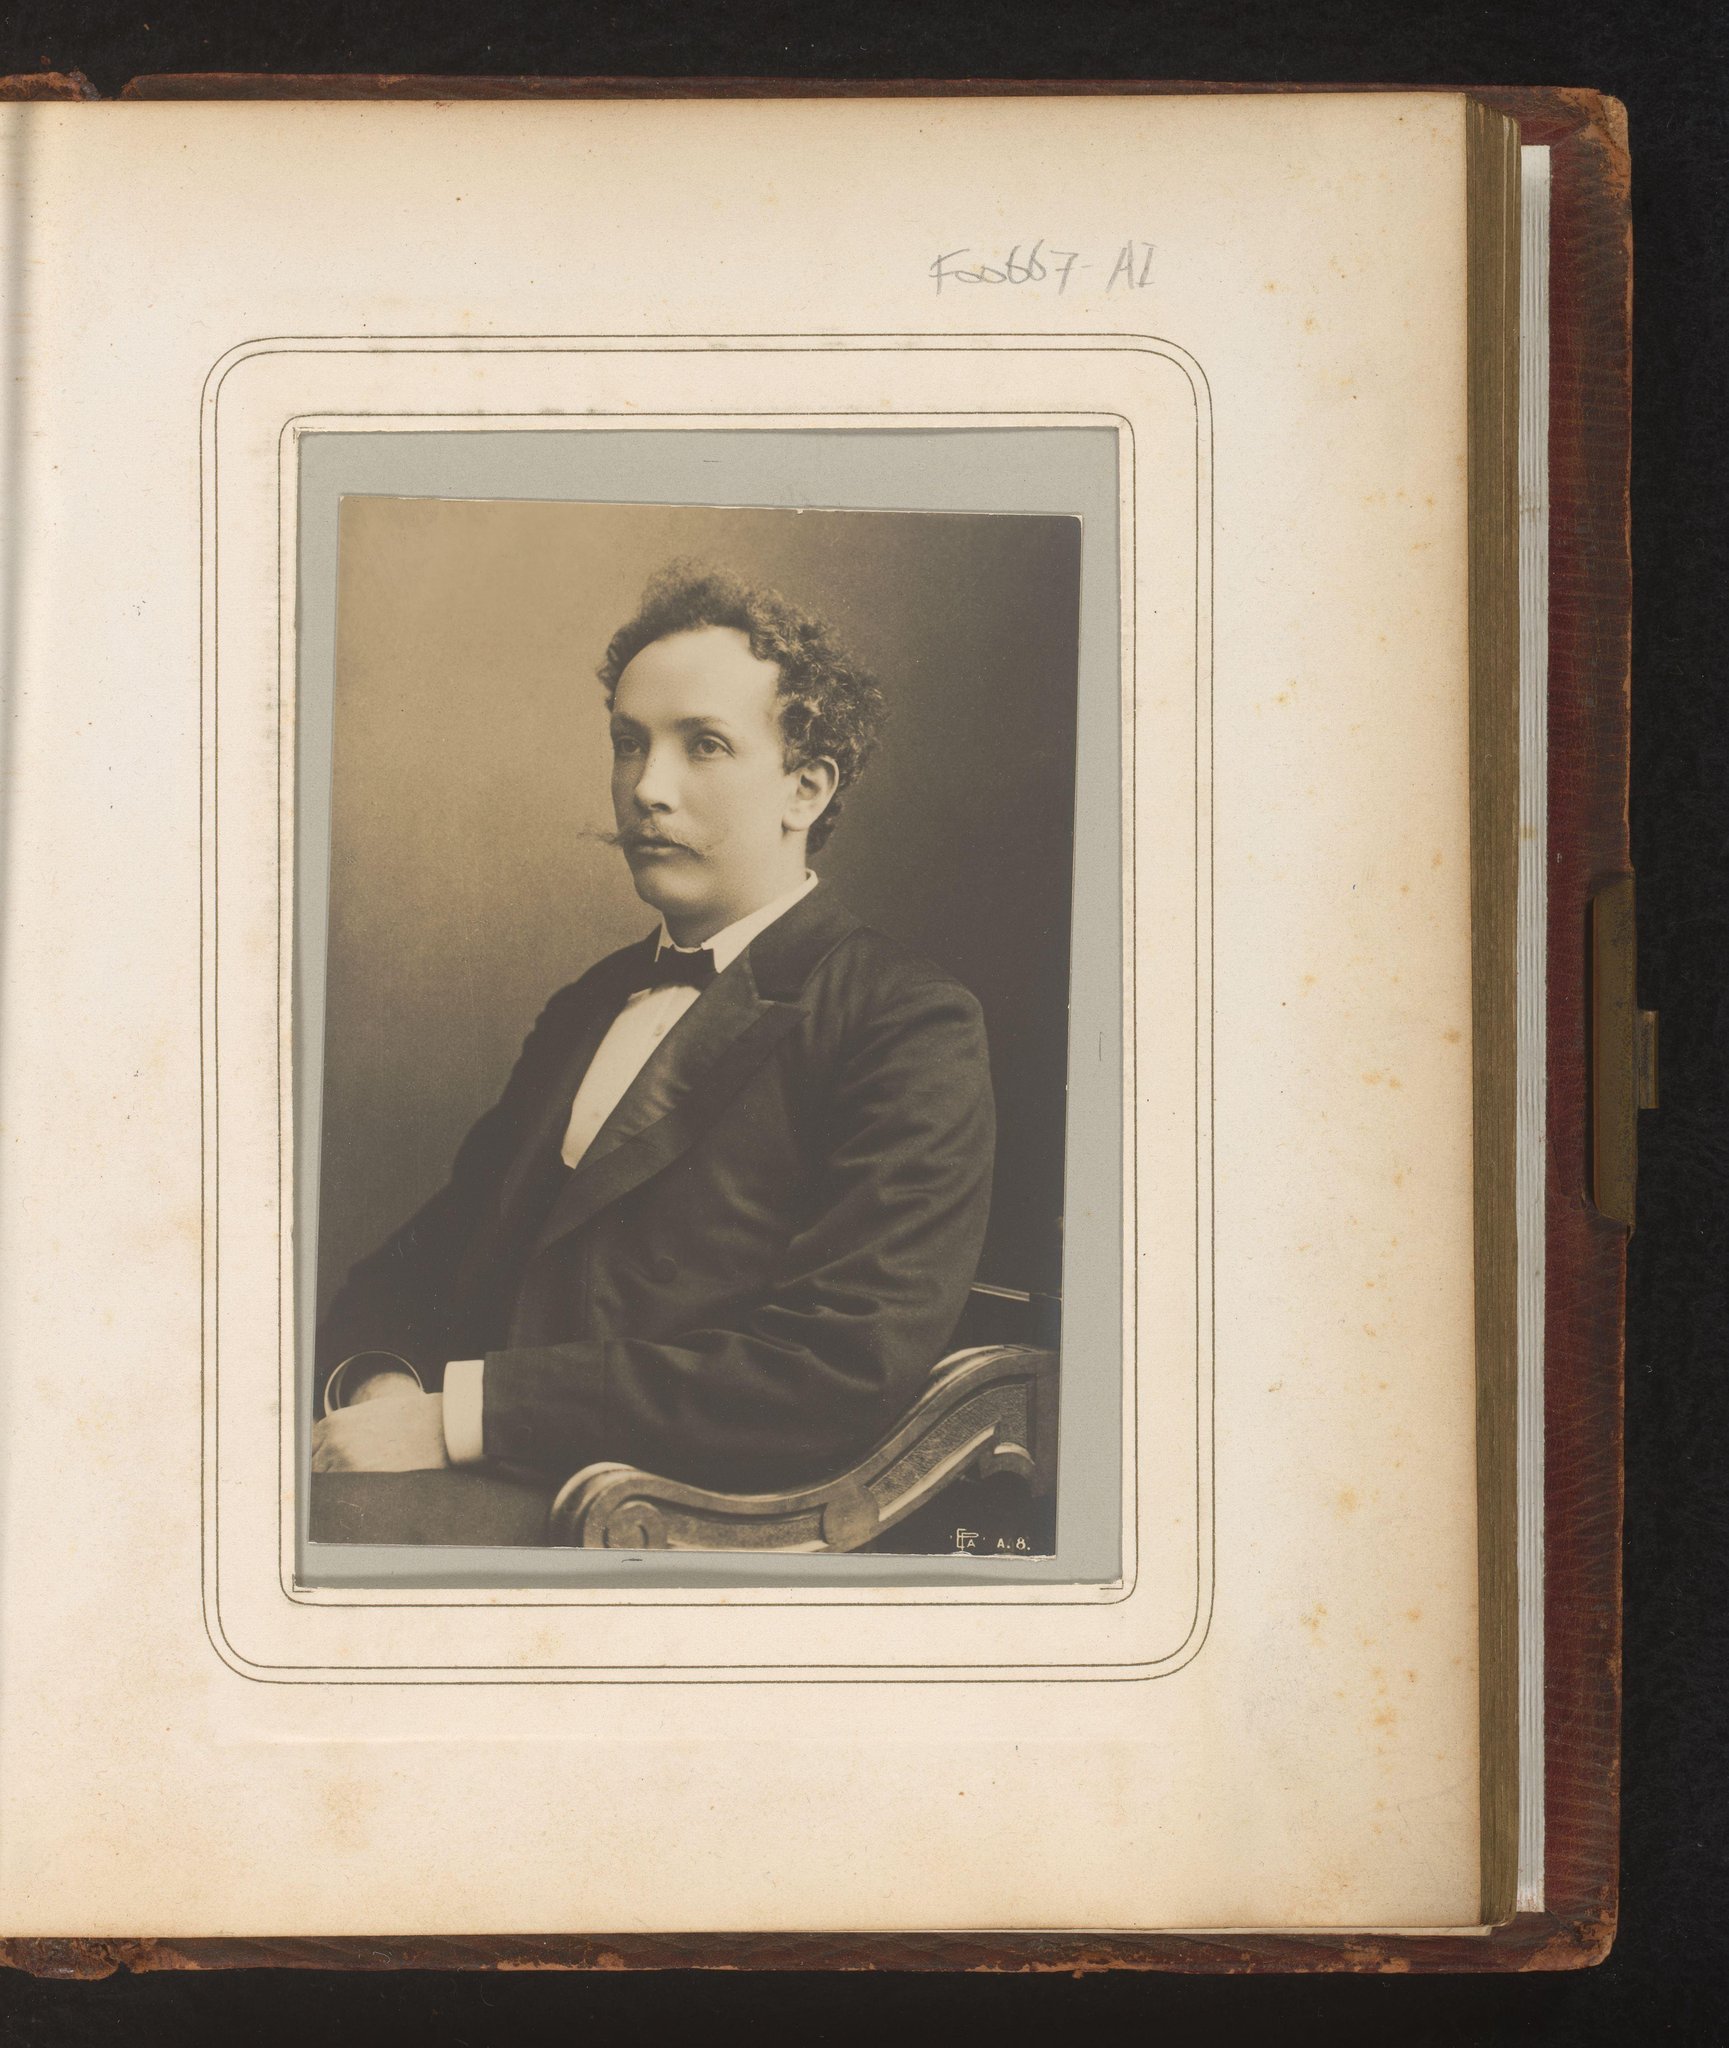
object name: photograph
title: Portret van een man gezeten in een stoel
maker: Anonymous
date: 1900-1920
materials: cardboard, photographic support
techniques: gelatin silver print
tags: adult man, historical persons